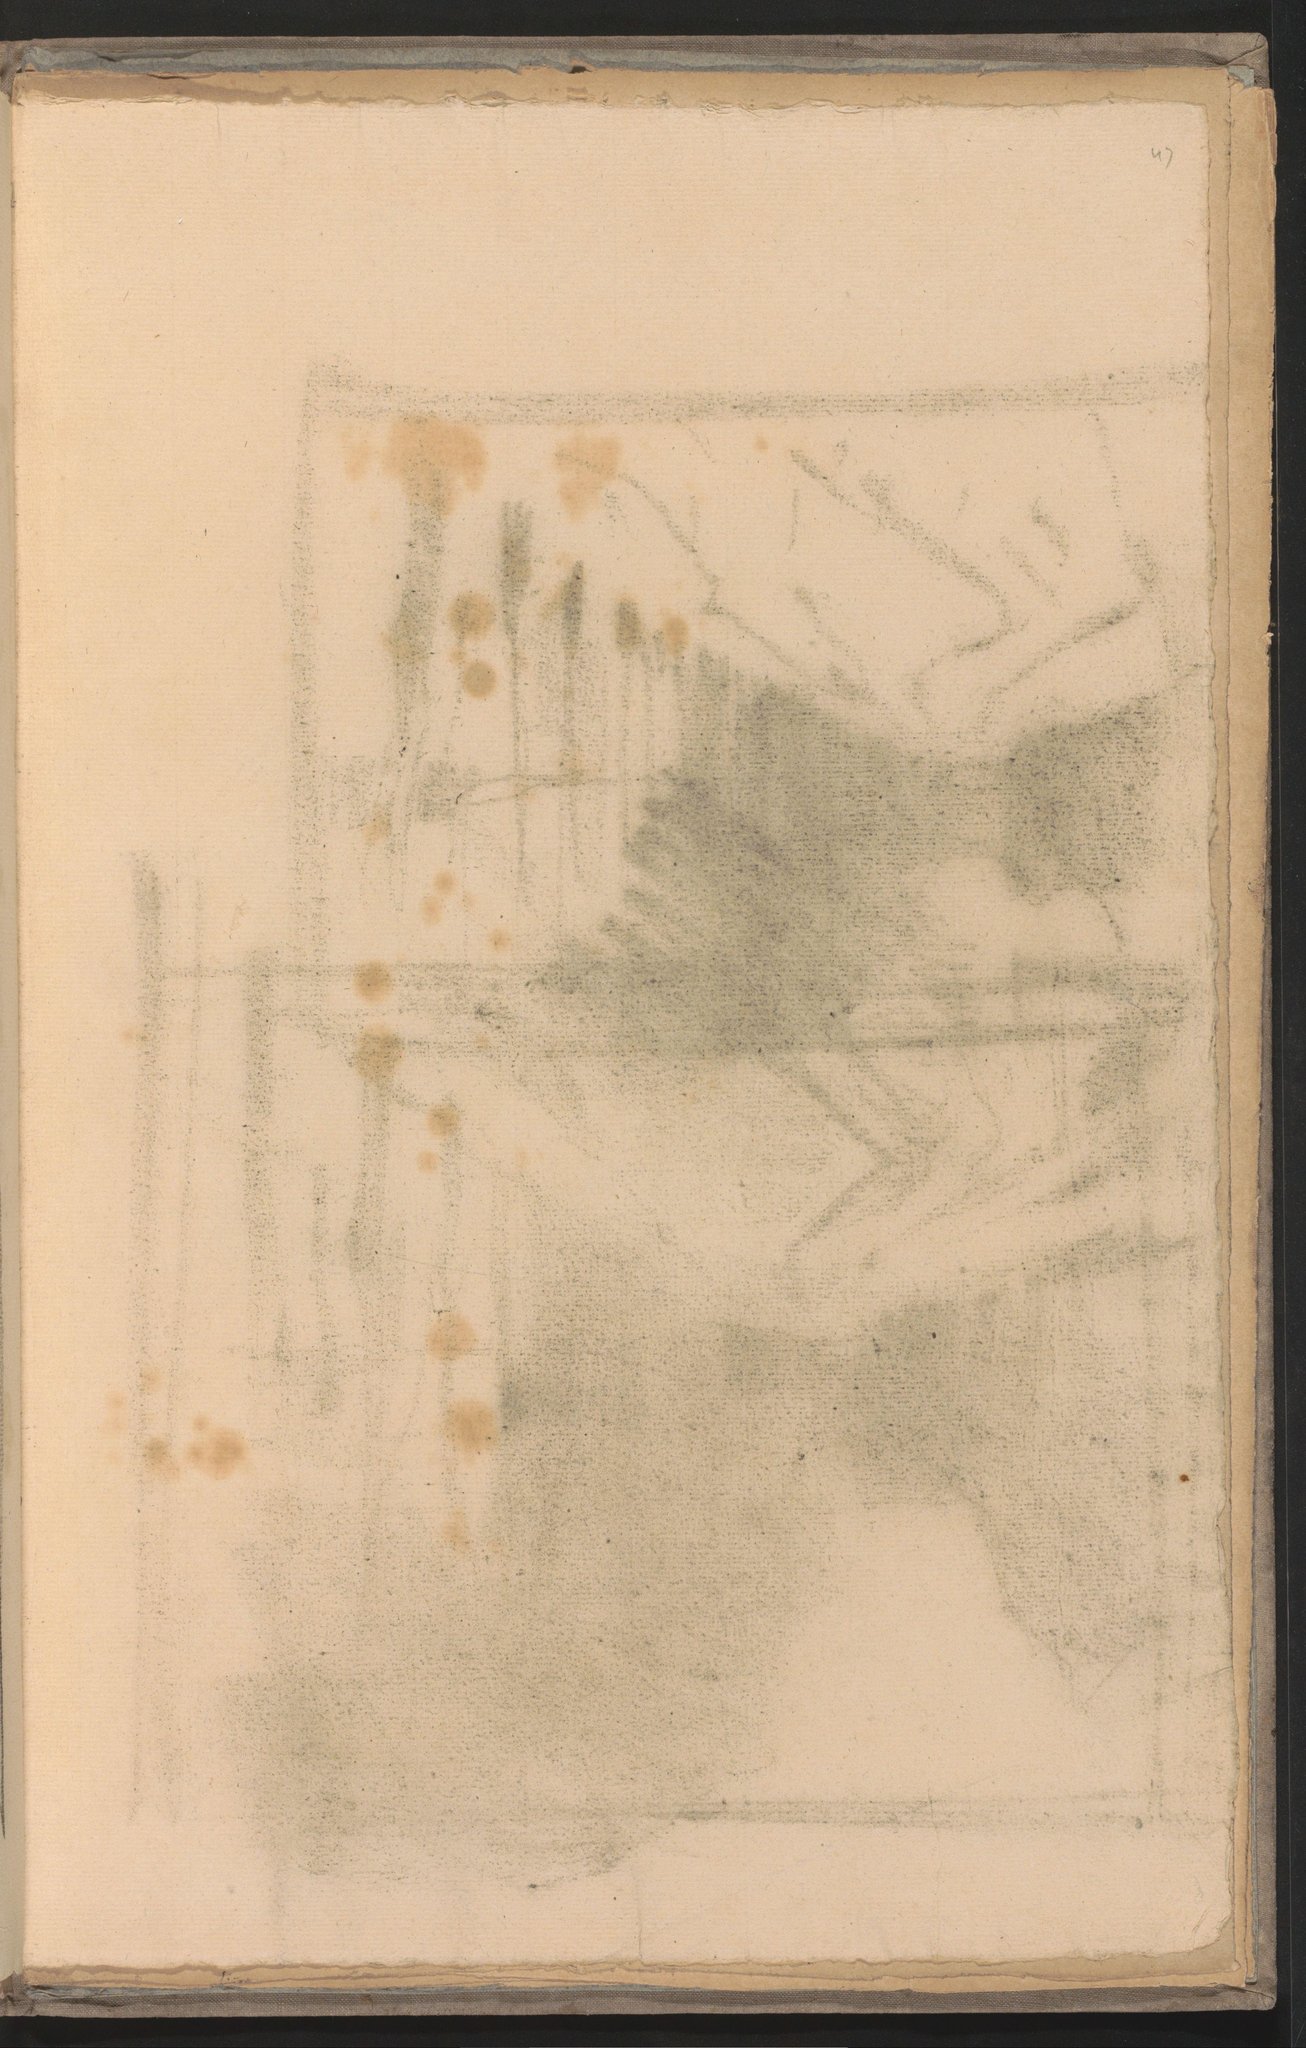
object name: sketchbook leaf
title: Abklatsch van de krijttekening op pagina 46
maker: willem witsen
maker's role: draughtsman, painter, print maker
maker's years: 1860-1923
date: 1886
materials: paper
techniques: printmaking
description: Pagina 47 uit een schetsboek met 38 bladen betekend rond de Ewijkshoeve.